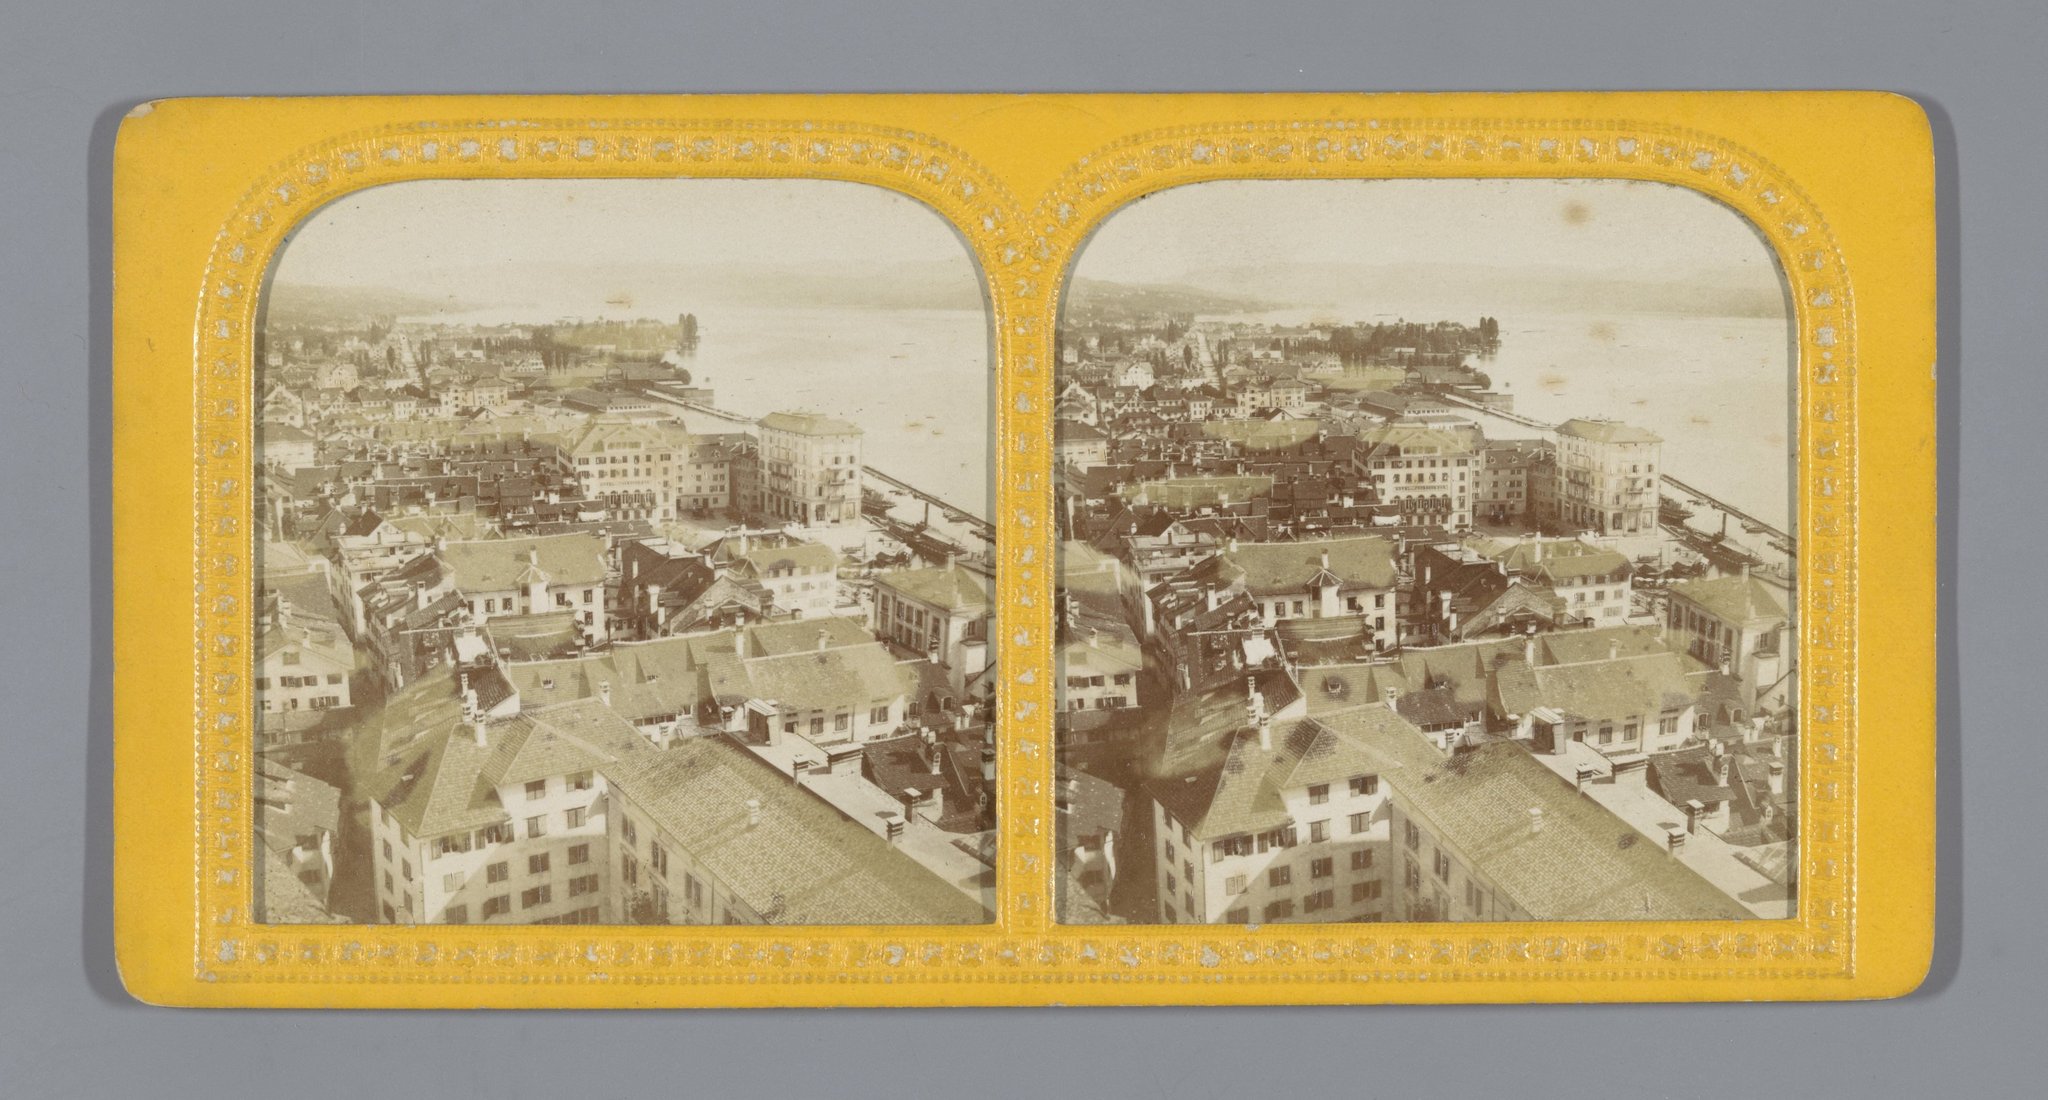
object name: tissue stereograph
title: Gezicht op Zürich, Zwitserland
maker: Anonymous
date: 1855-1875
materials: cardboard, paper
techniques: albumen print, cutting, hand coloring, perforating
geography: zurich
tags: city-view in general; 'veduta'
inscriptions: number: ‘No. 3127’, inscription: ‘[...]/ 50’